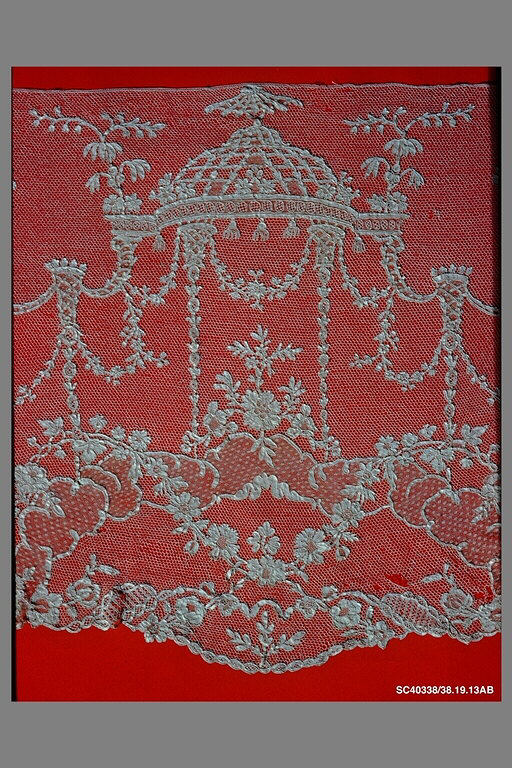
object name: flounce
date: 1750-1759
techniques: lace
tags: flowers